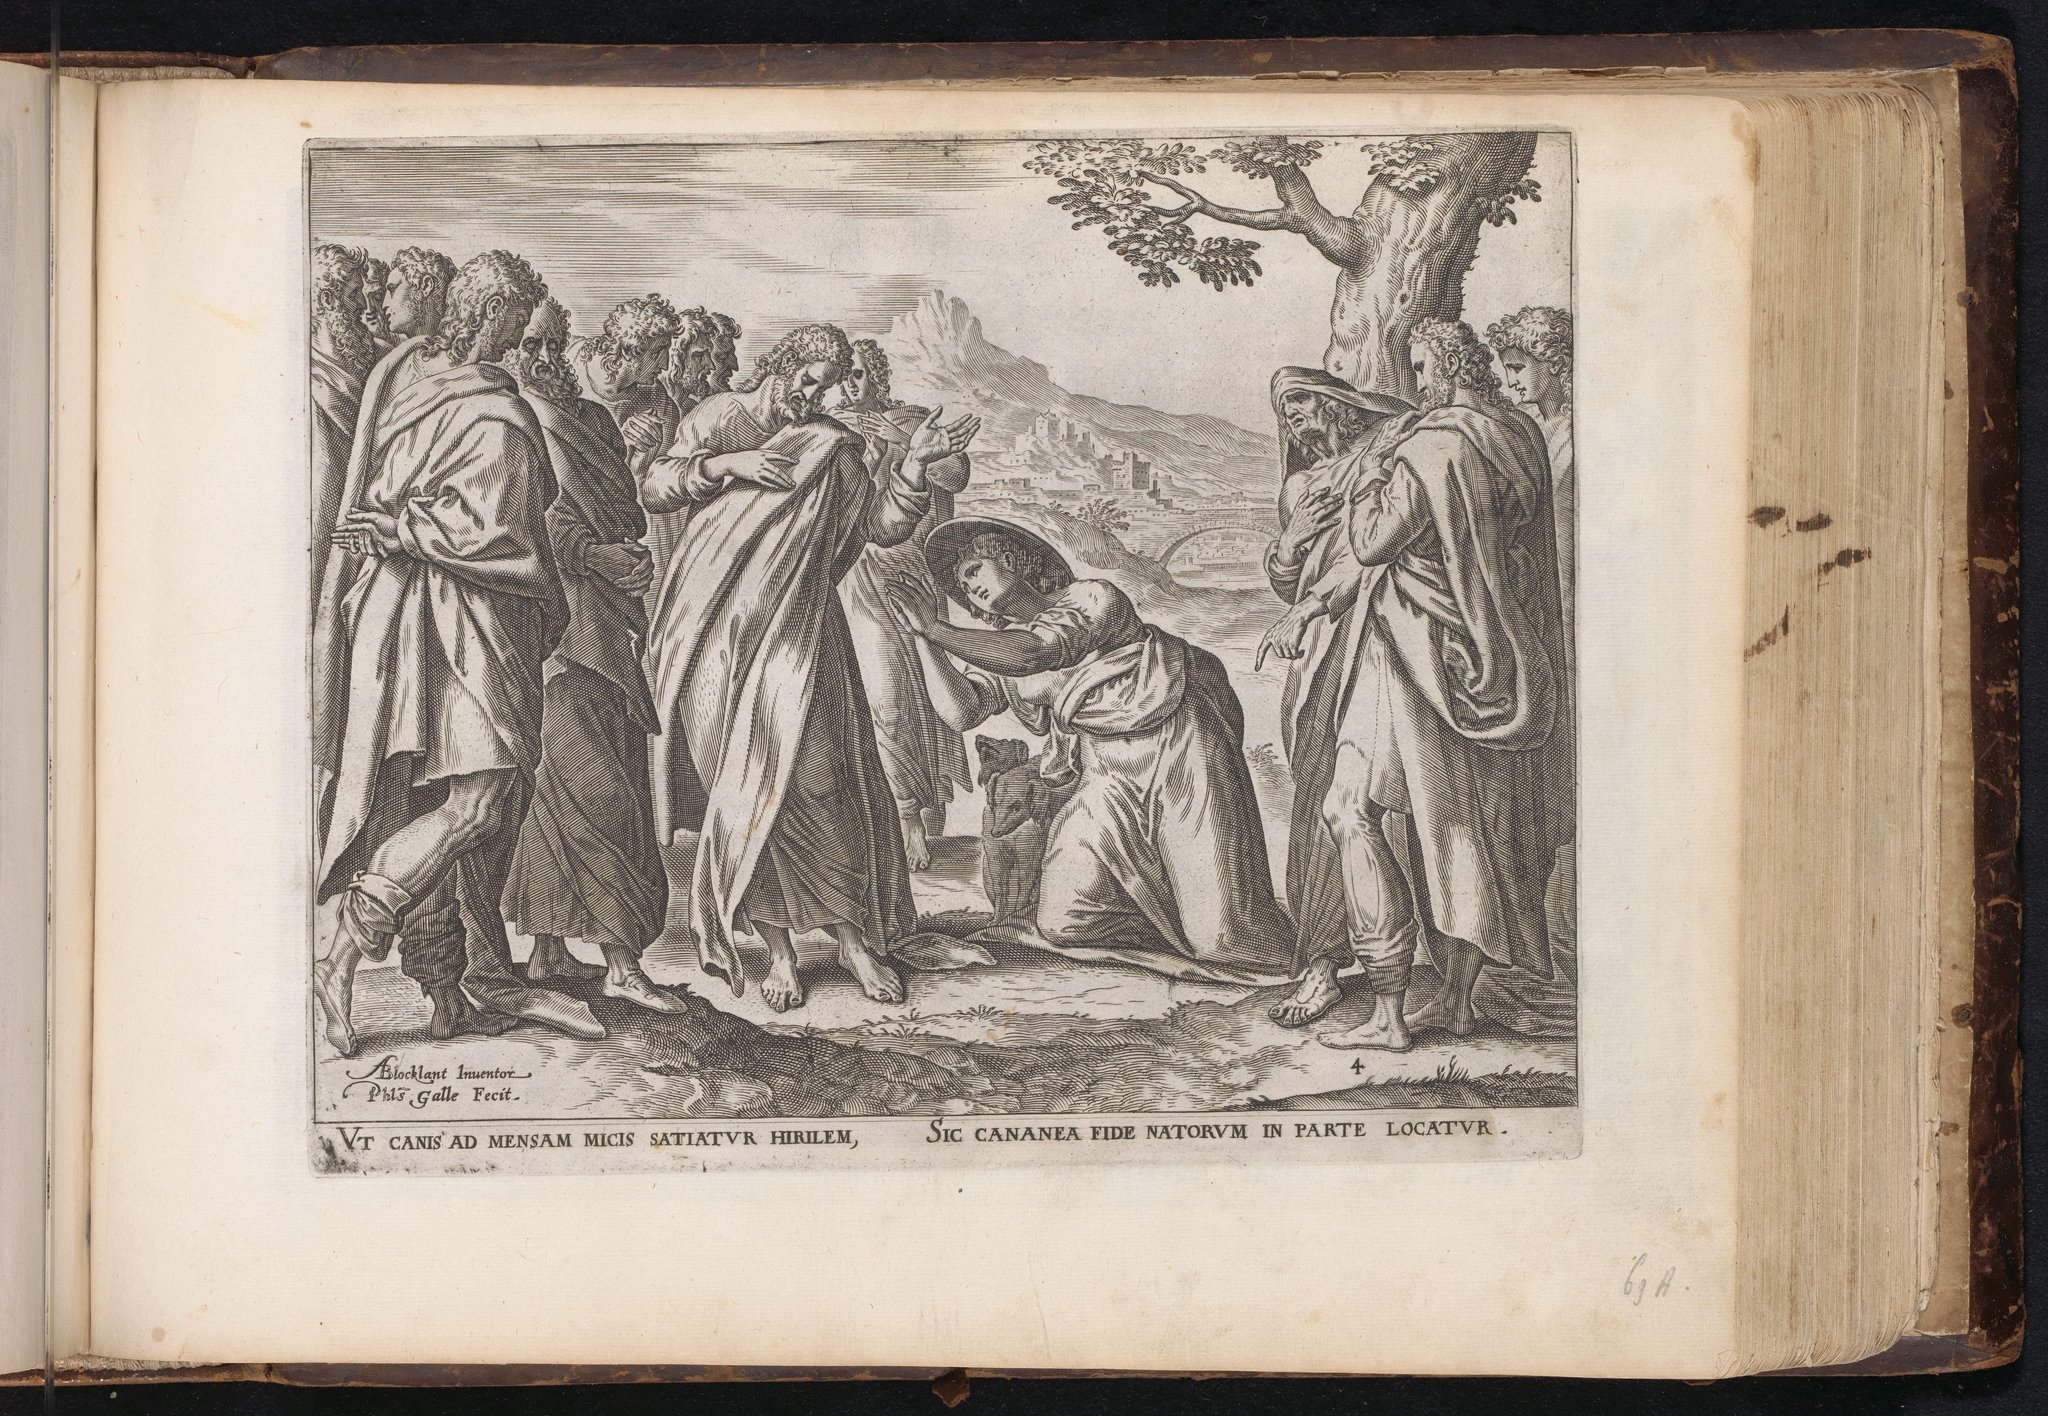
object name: album leaf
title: Den Grooten Figuer-Bibel (...)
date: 1575-1581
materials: paper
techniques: engraving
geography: amsterdam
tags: a canaanite woman kneels before christ, asking him to heal her daughter; the metaphor of the dogs and bread (matthew 15:21-28; mark 7:24-30)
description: De Kanaänitische vrouw knielt voor Christus en vraagt hem om haar dochter te bevrijden van een demon. Naast haar zitten twee honden. Onder de voorstelling een verwijzing in het Latijn naar de Bijbeltekst. Deze prent maakt deel uit van een album.